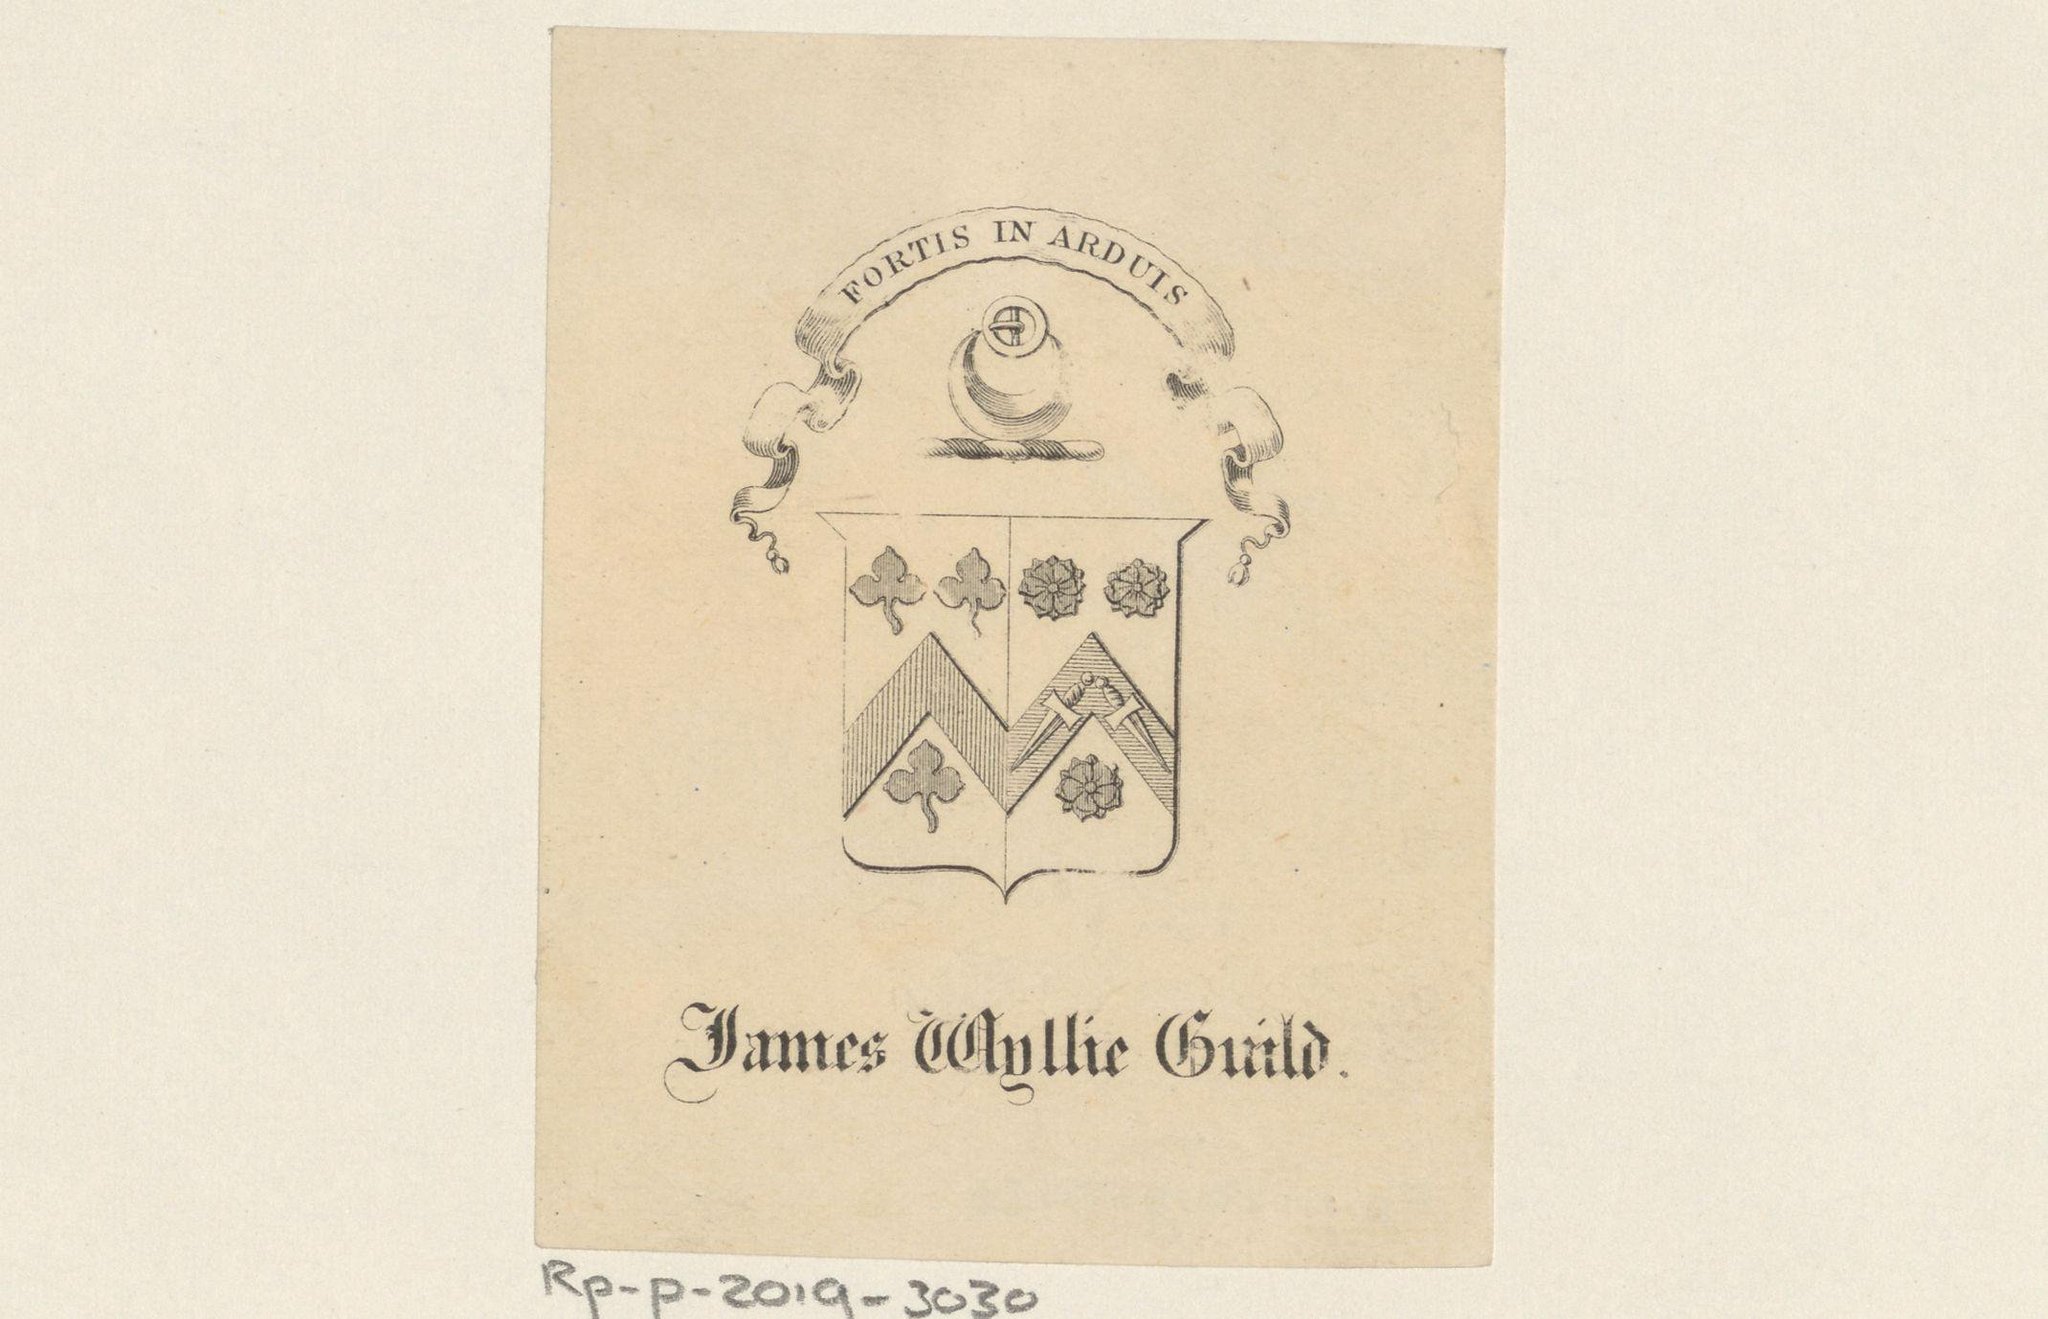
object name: bookplate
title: Ex libris van James Wyllie Guild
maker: Anonymous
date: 1800-1899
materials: paper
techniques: etching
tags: armorial bearing, heraldry